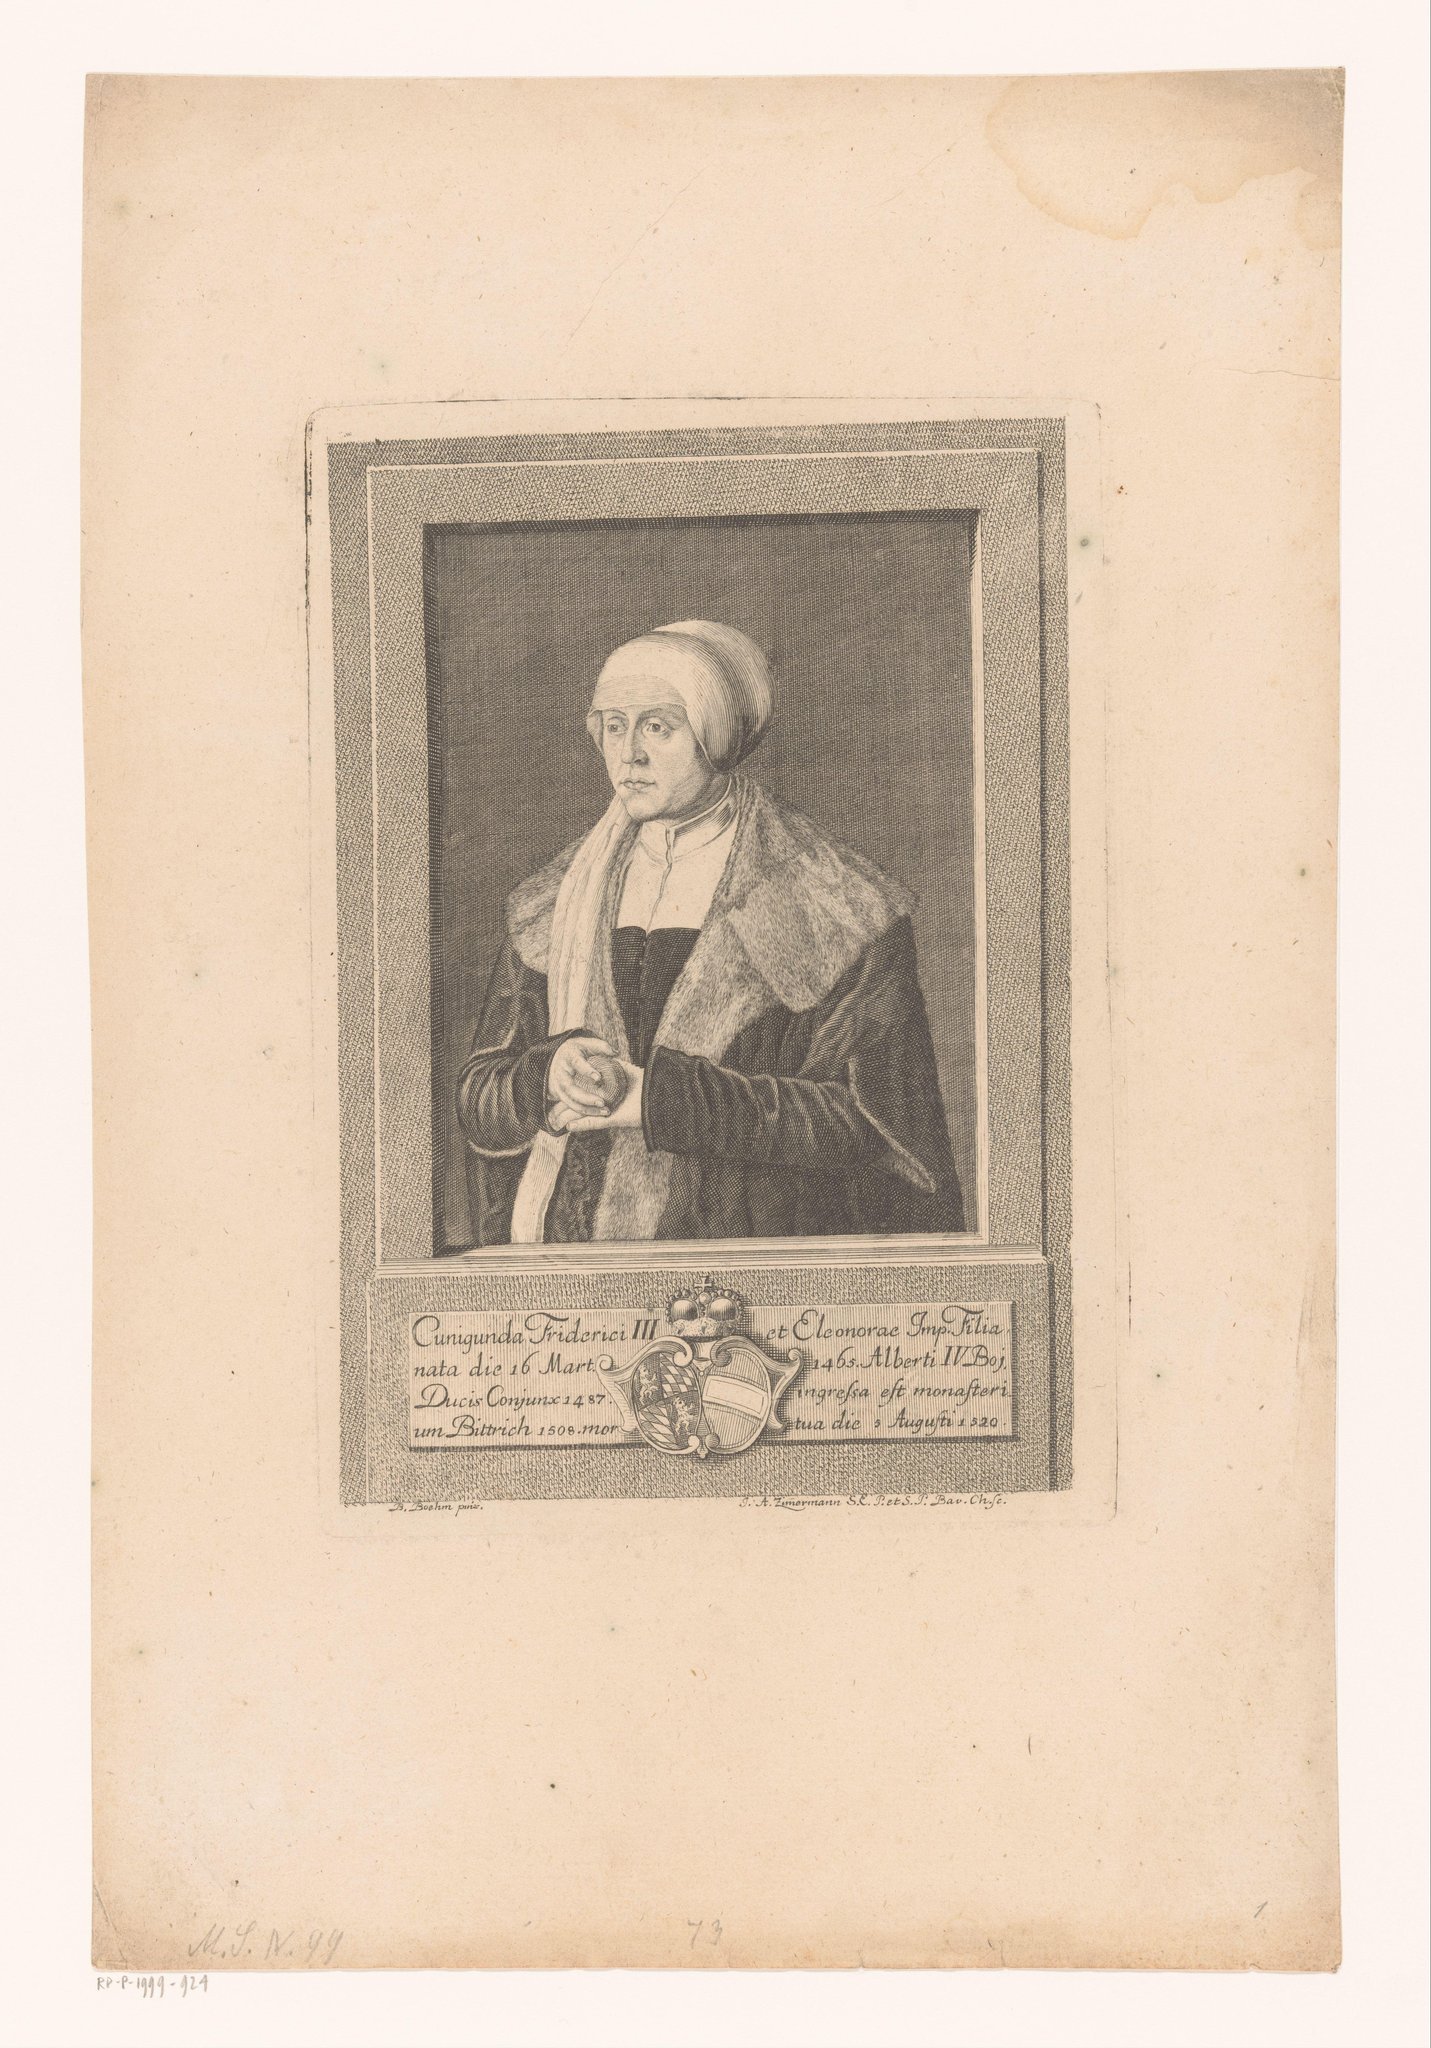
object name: print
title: Portret van Kunigunde van Oostenrijk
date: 1773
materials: paper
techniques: engraving, etching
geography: germany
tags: historical persons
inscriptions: collector's mark: Lugt 2228, collector's mark: Lugt 4100, collector's mark: Lugt 2760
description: Prent gebruikt voor de publicatie: Zimmermann, Joseph Anton. Series Imaginum Augustae Domus Boicae. München: s.n., 1773.